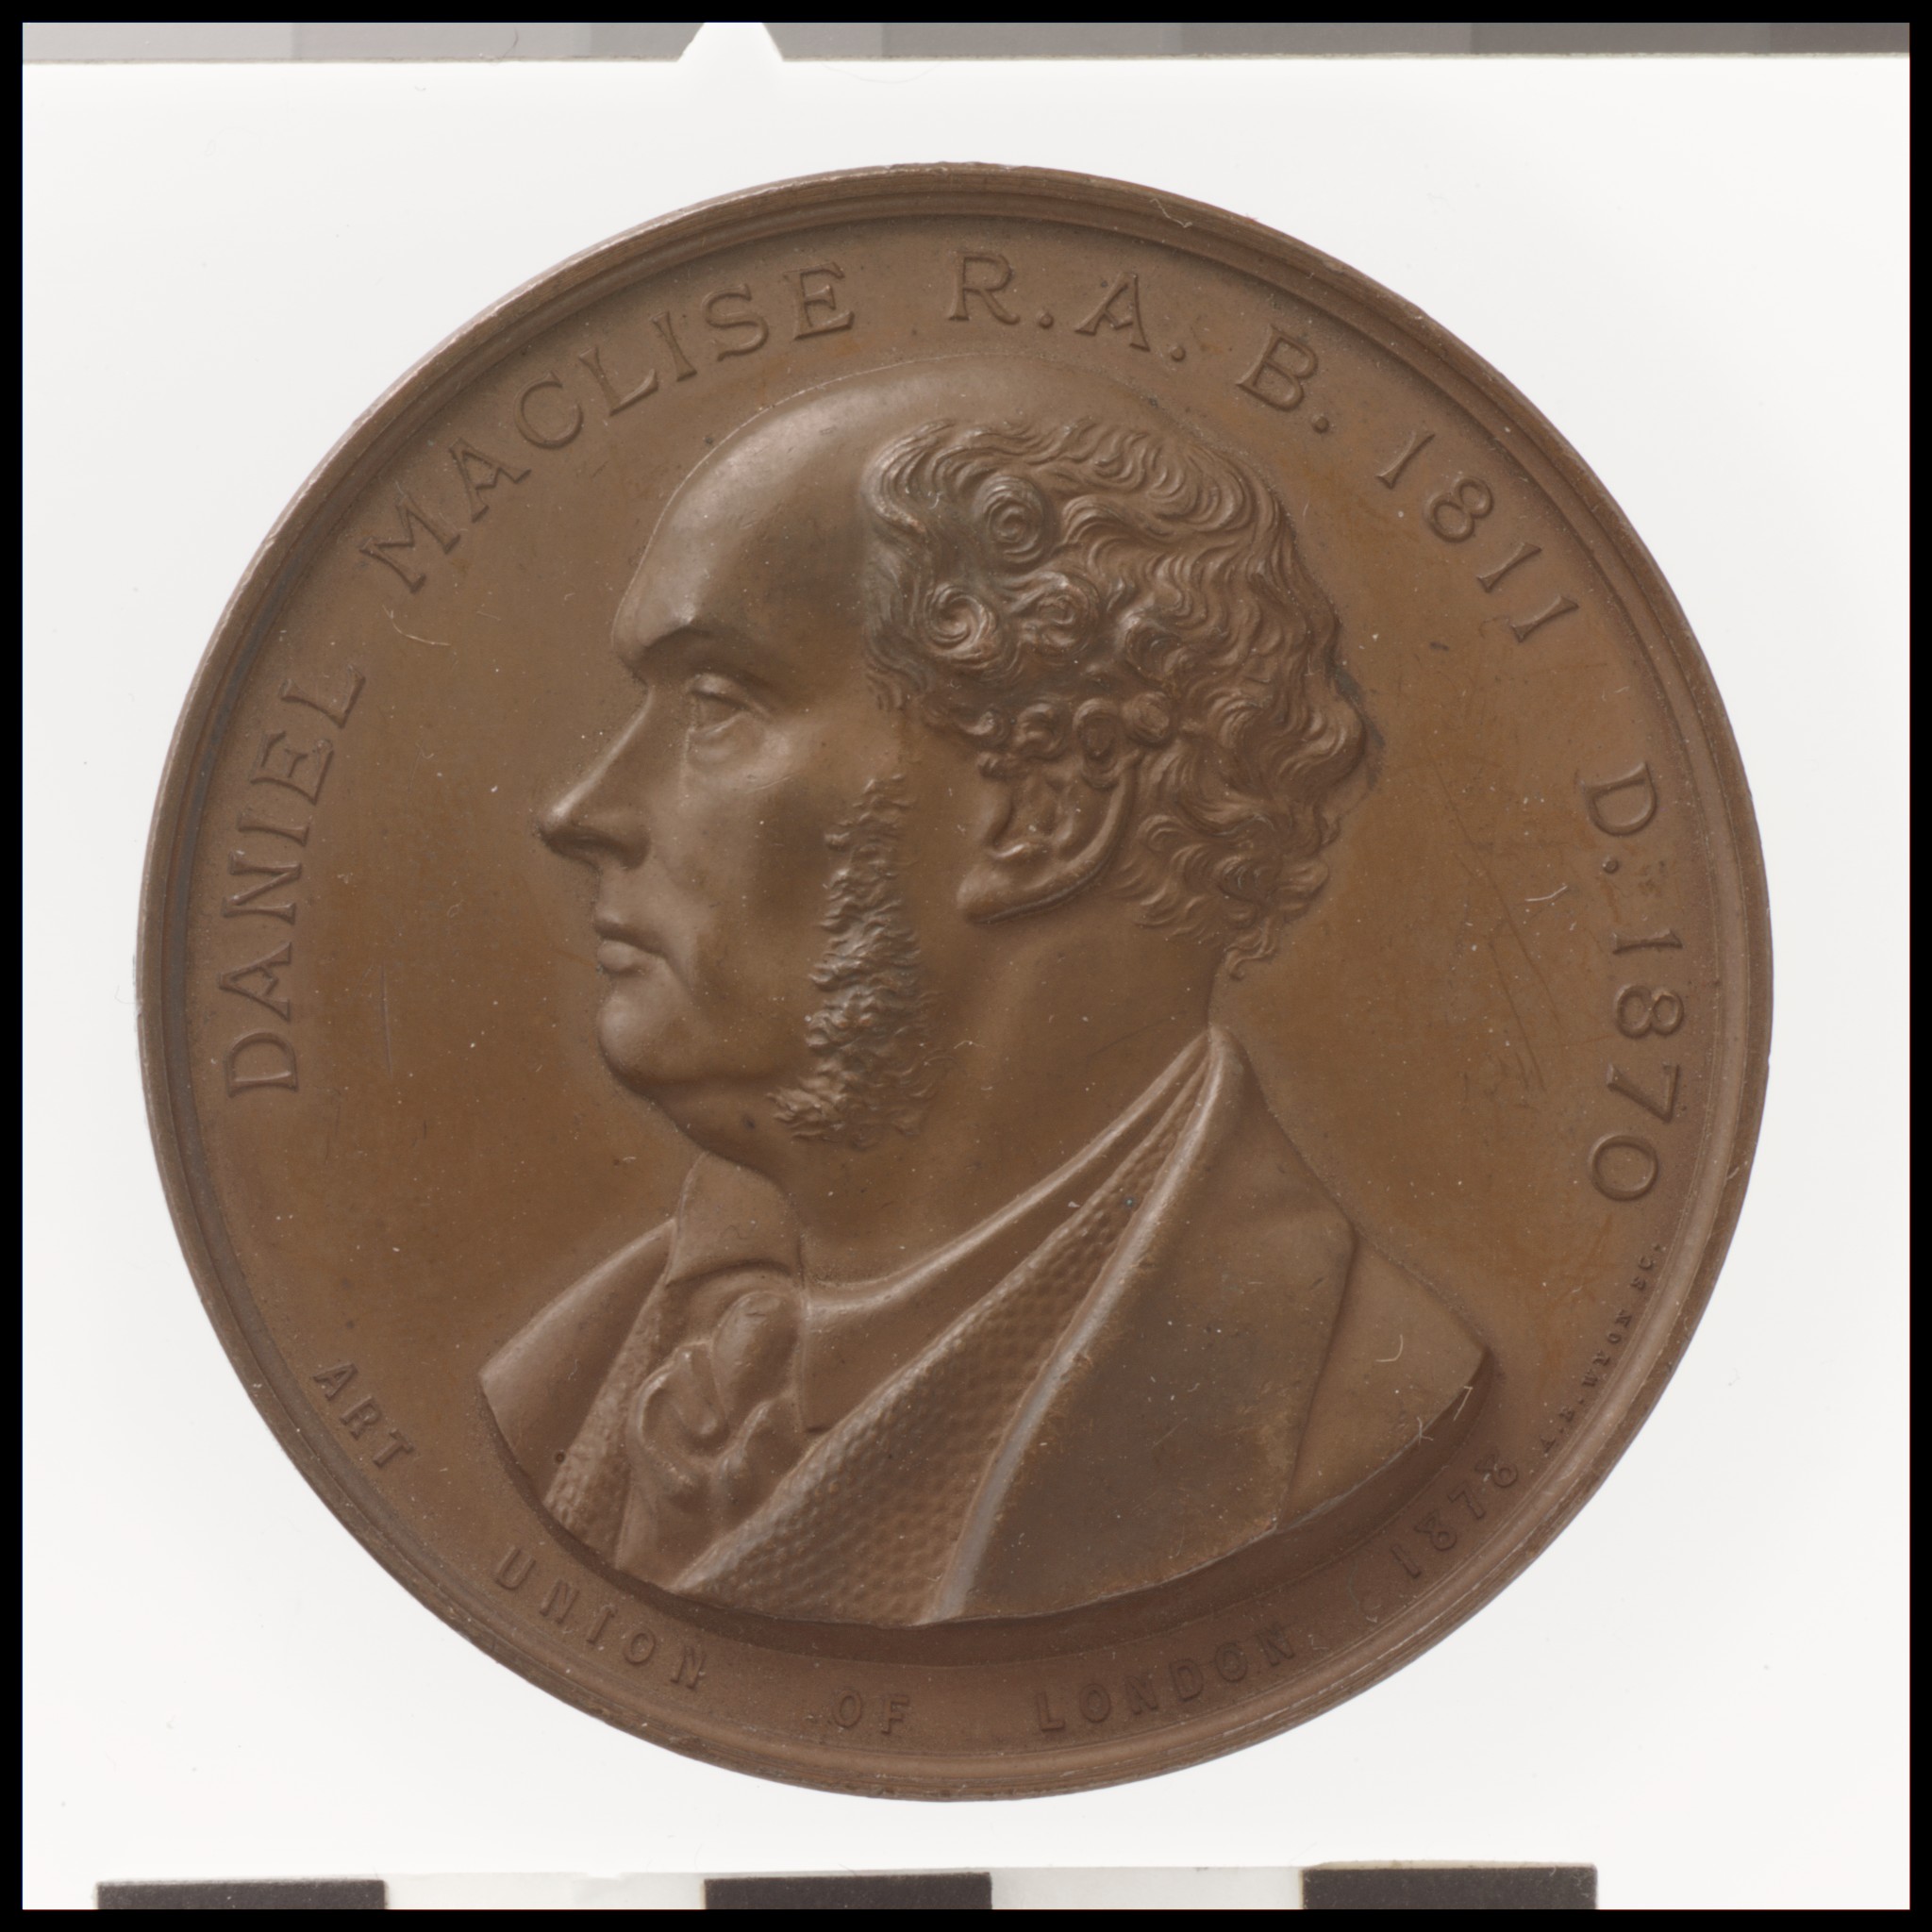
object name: medal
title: Daniel Maclise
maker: alfred benjamin wyon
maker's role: maker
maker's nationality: british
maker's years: 1837-1884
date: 1875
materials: bronze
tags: kings,men,profiles